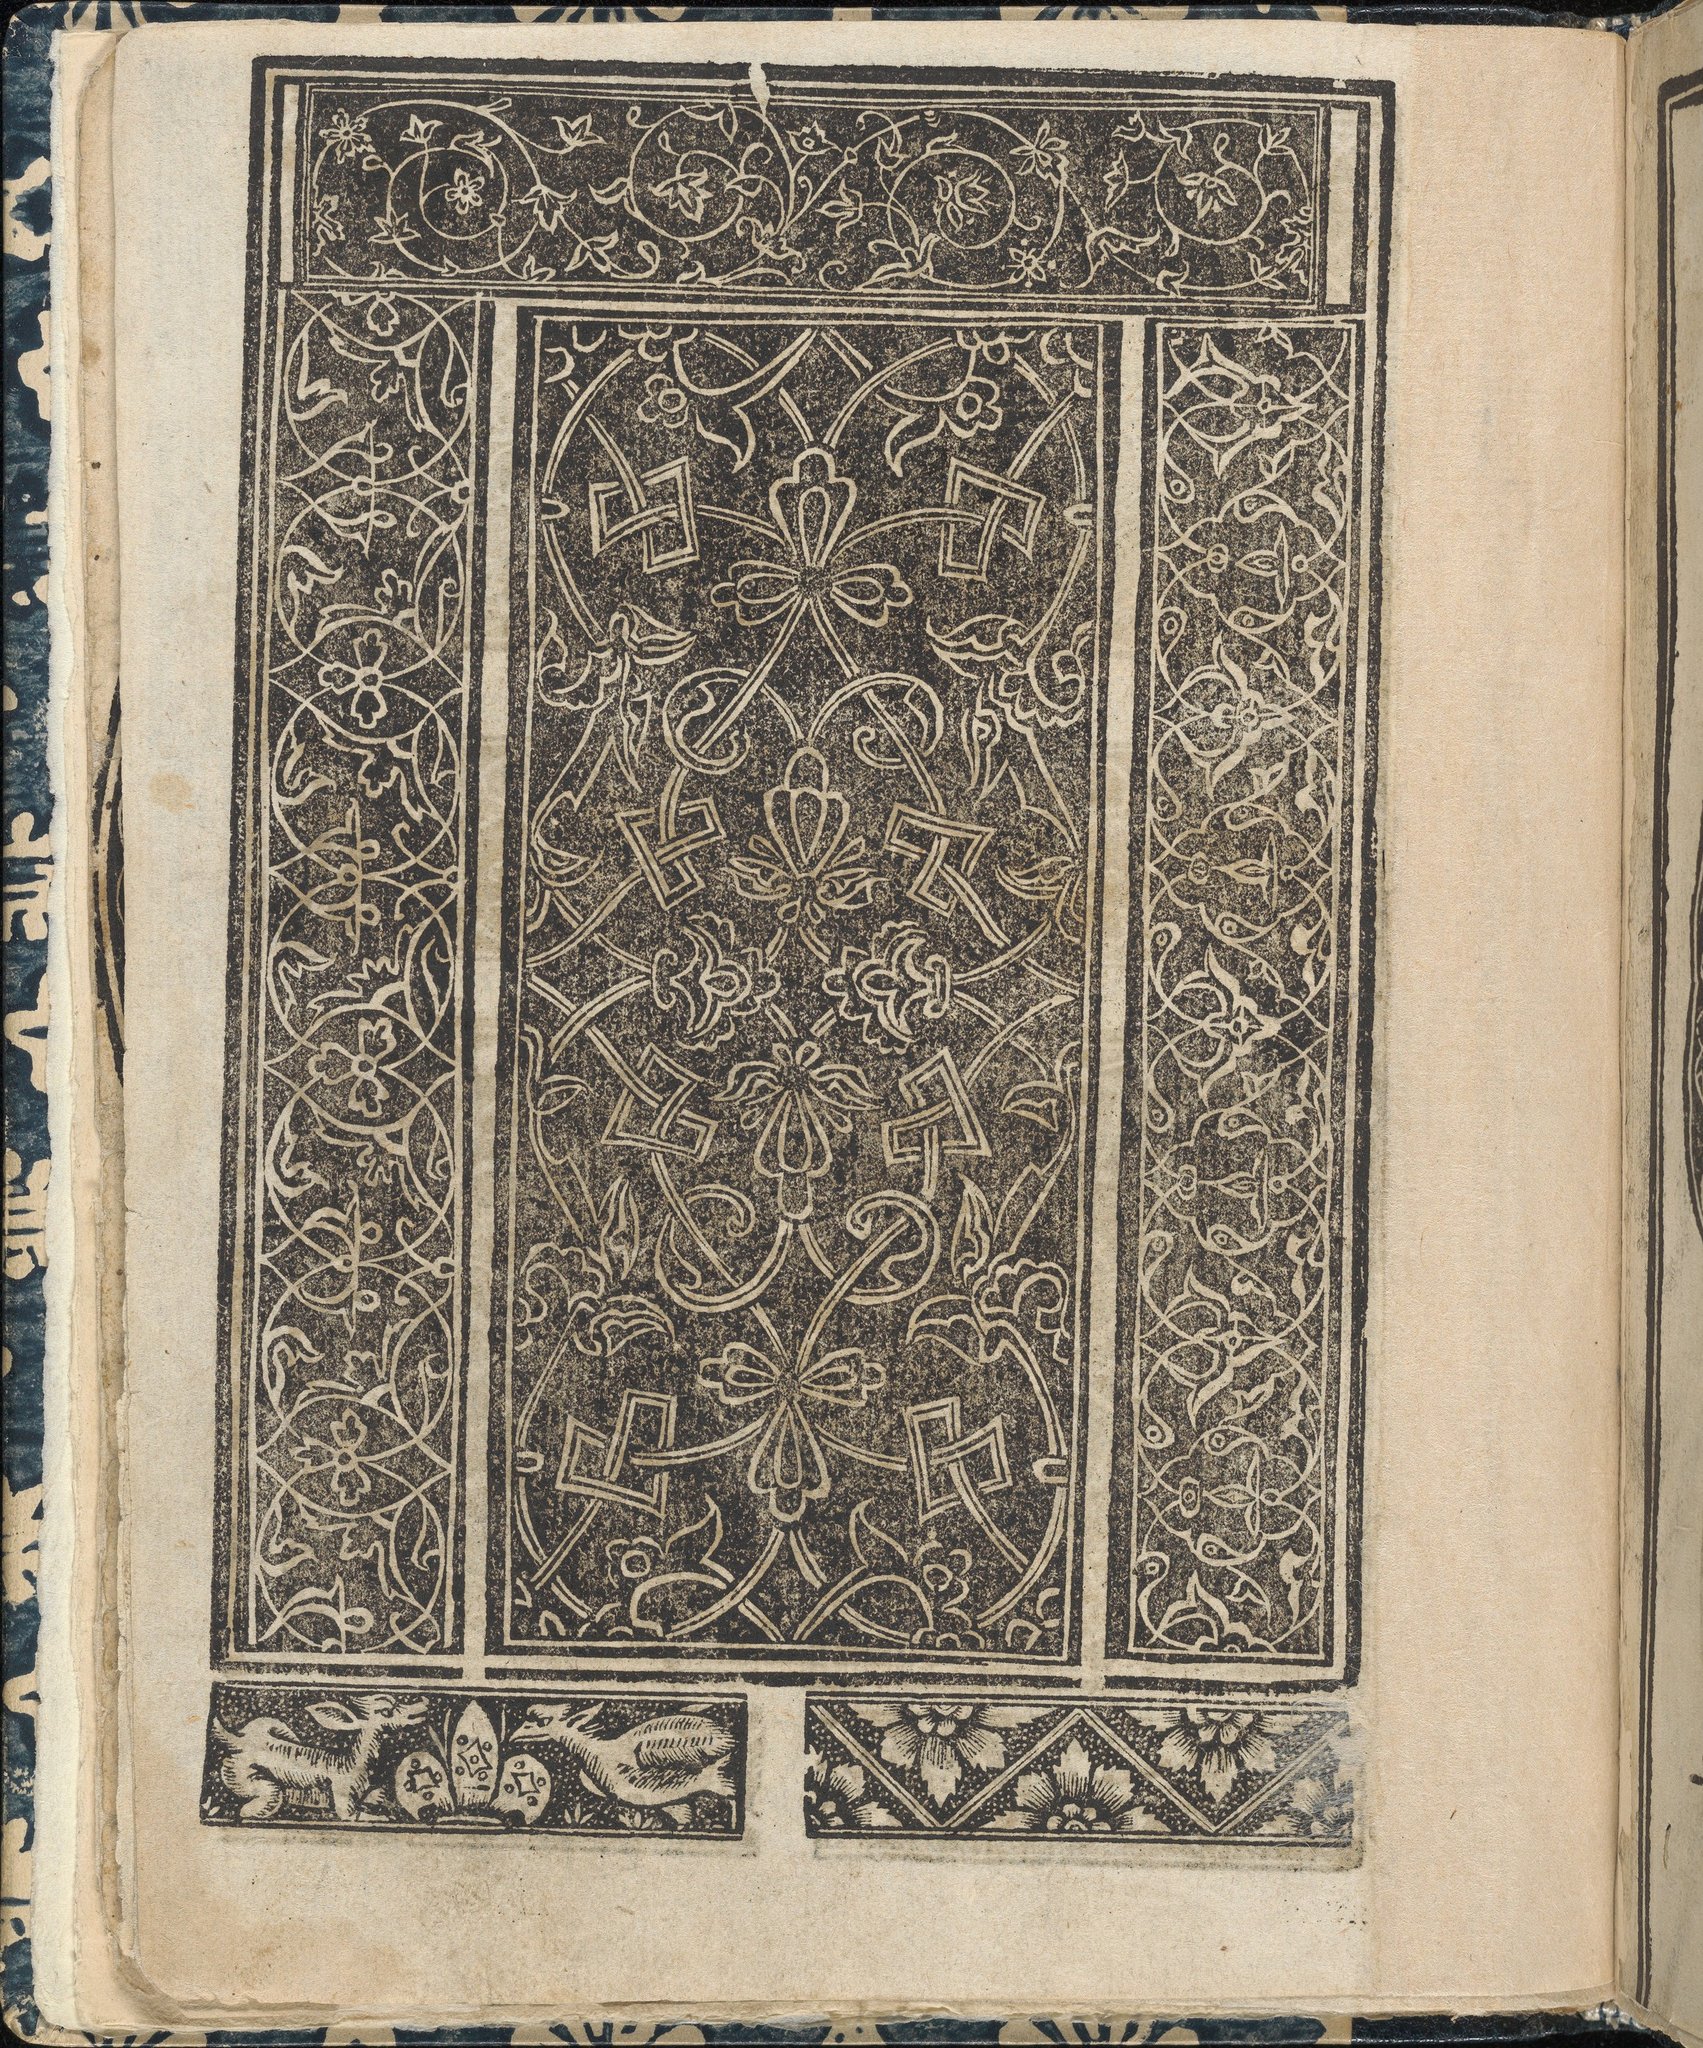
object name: book print ornament architecture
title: Essempio di recammi, page 14 (verso)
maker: giovanni antonio tagliente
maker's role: author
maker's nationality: italian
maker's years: 1465-1528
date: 1530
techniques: woodcut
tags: birds,ornament,dogs,flowers